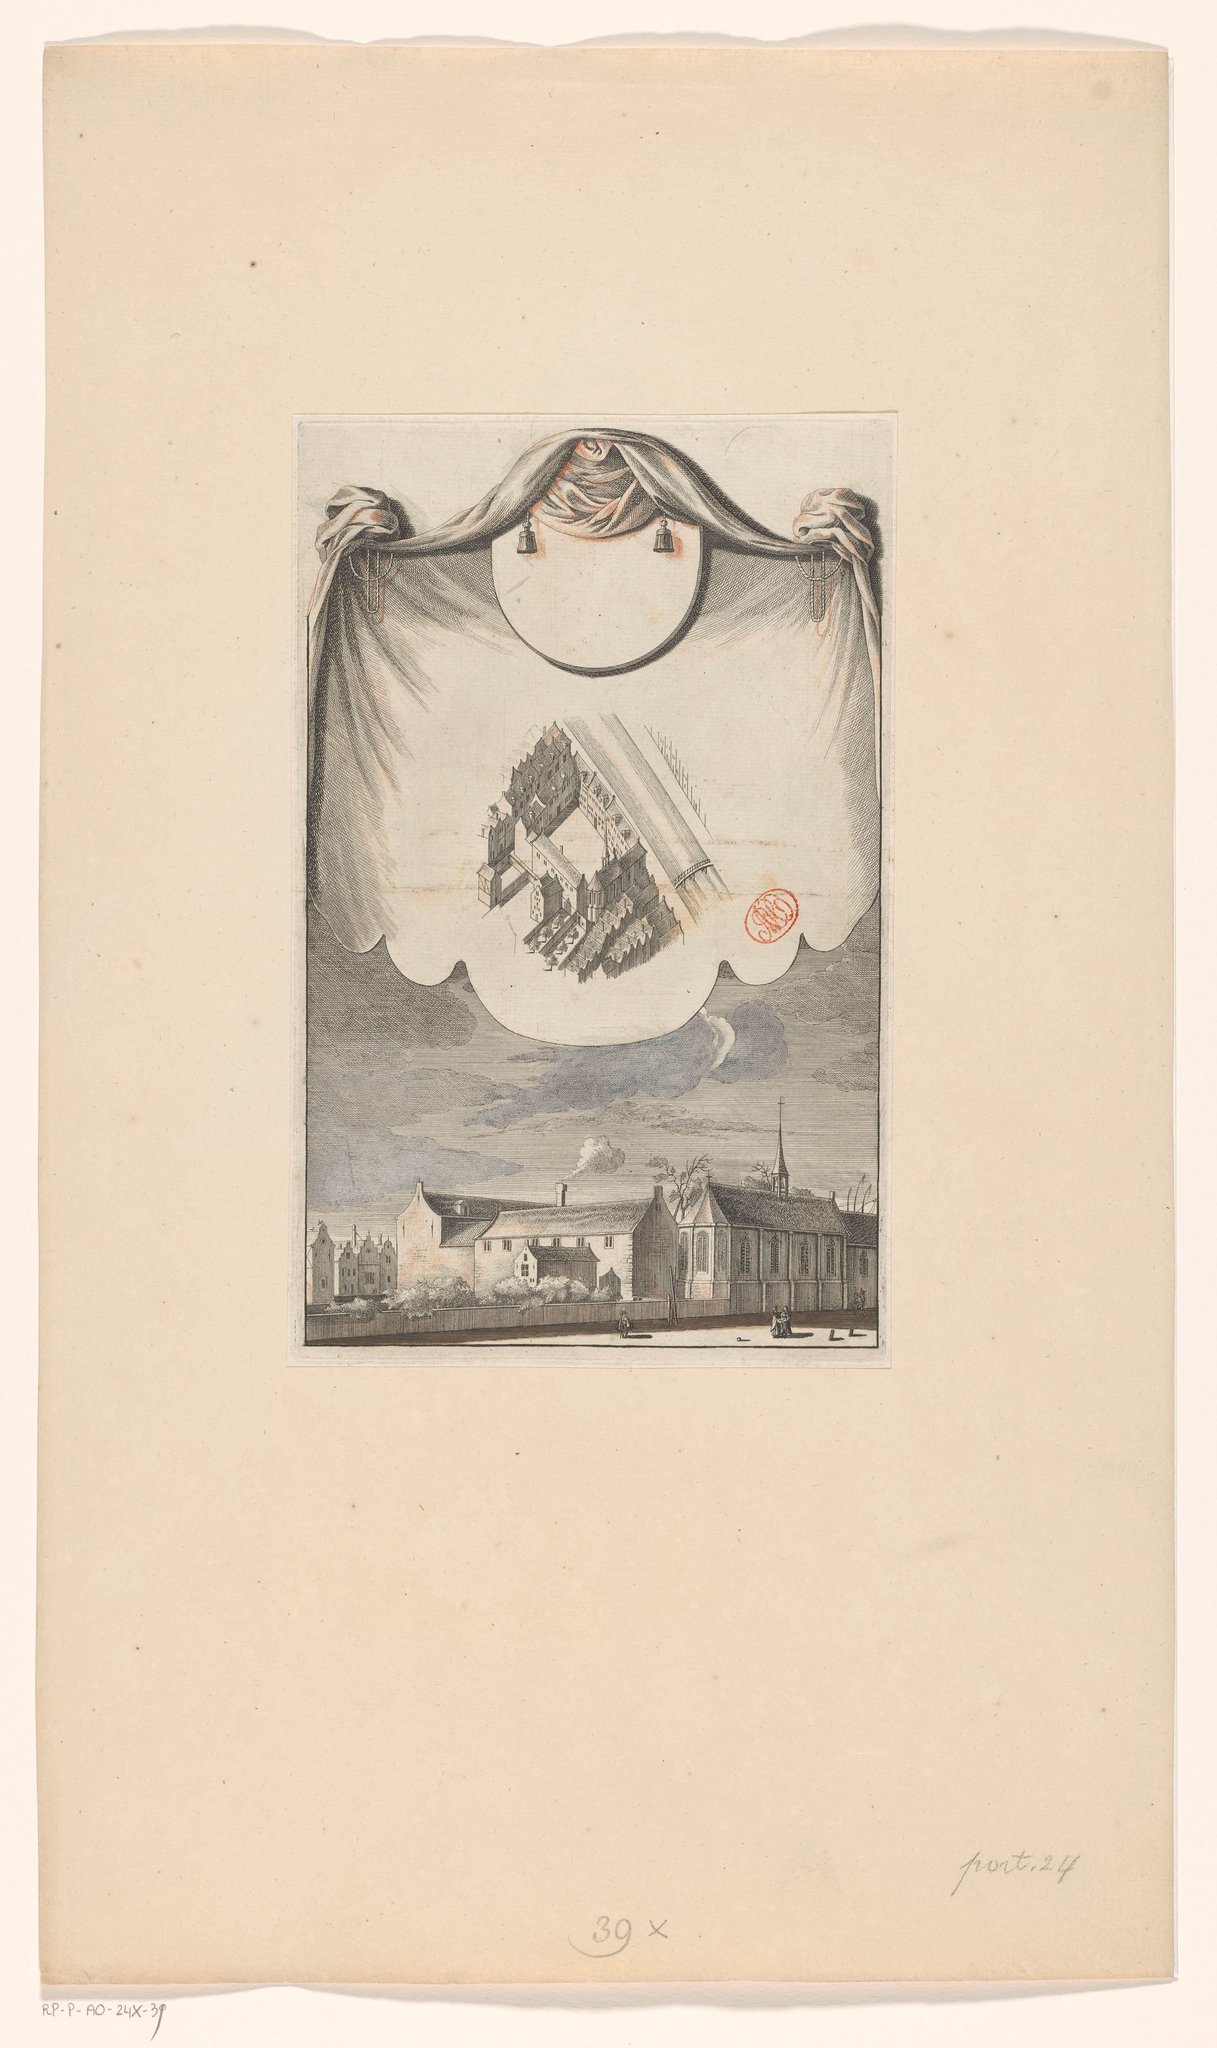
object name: print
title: Gezichten op het Sint-Geertruidenklooster te Amsterdam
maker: Anonymous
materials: chalk, paint, paper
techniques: brush, engraving, etching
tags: abbey, monastery, convent ~ roman catholic church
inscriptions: collector's mark: Lugt 2233, collector's mark: Lugt 195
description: Latere staat van prent ook gebruikt in: Wagenaar, Jan. Amsterdam, in zyne opkomst, aanwas, geschiedenissen (…). 3 delen [folio-uitgave]. Amsterdam: Isaak Tirion en Yntema & Tieboel, 1760-1767, dl. 1 (Isaac Tirion, 1760). Zie RP-P-AO-24X-38 voor tweede staat. Dat de prent de situatie rond 1544 weergeeft gaat terug op het feit dat voor het maken van deze en andere prenten van kloosters en kerken van voor de Alteratie (1578) is uitgegaan van de plattegrond van Cornelis Anthonisz. uit 1544 (zie RP-P-OB-70.399 en RP-P-AO-20-15).